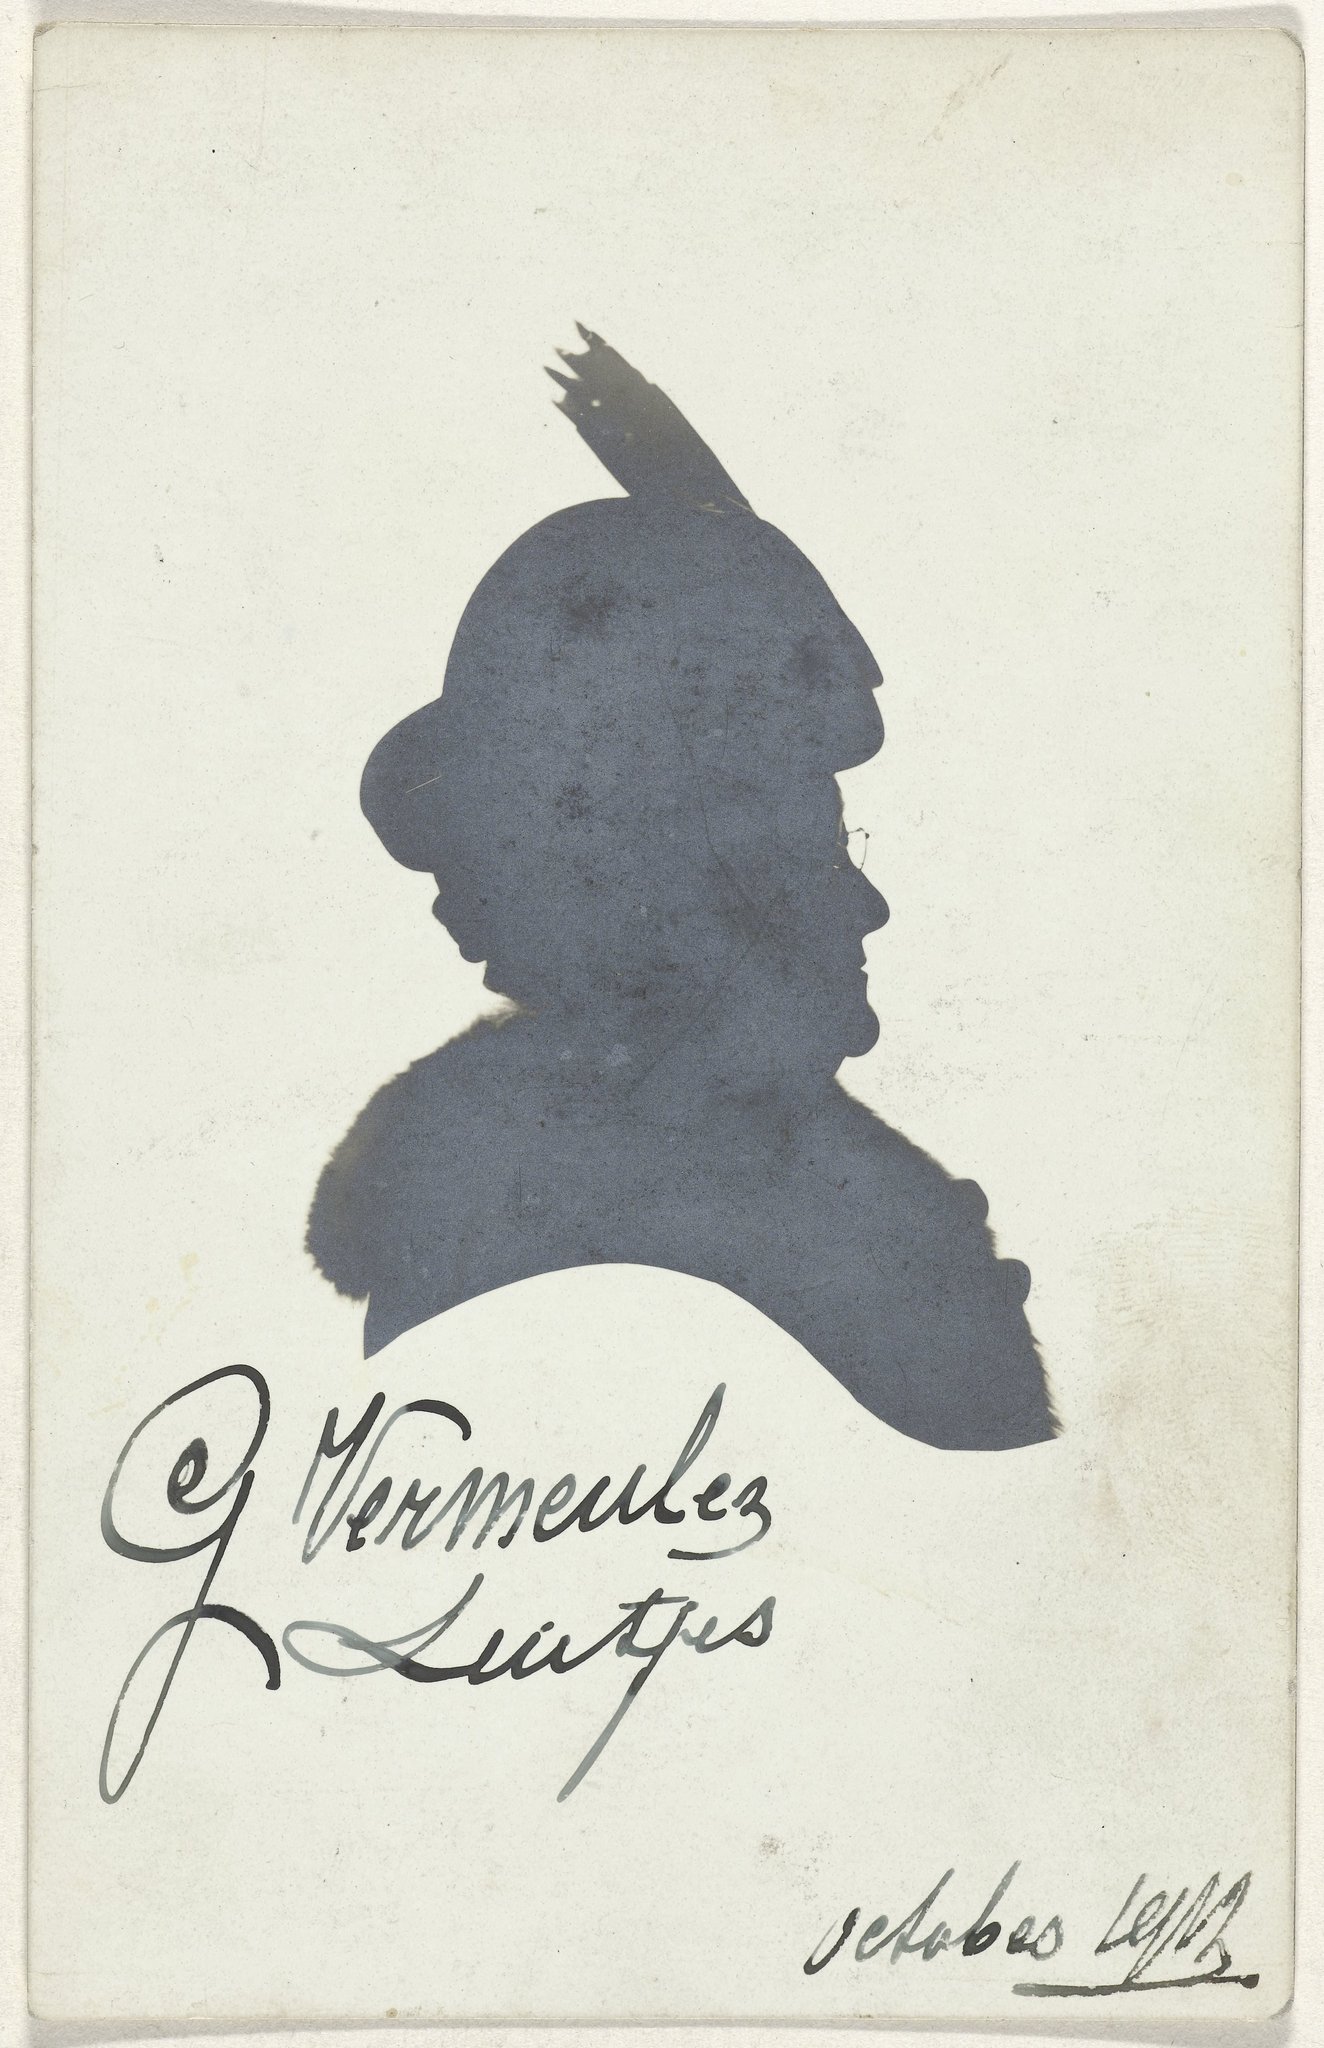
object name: photograph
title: Silhouetportret van Grietje Vermeulen-Luitjes, echtgenote van de fotograaf C.J.L. Vermeulen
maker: Anonymous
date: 1912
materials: cardboard, paper, photographic support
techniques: gelatin silver print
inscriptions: inscription: ‘G Vermeulen / Luitjes / october 1912’